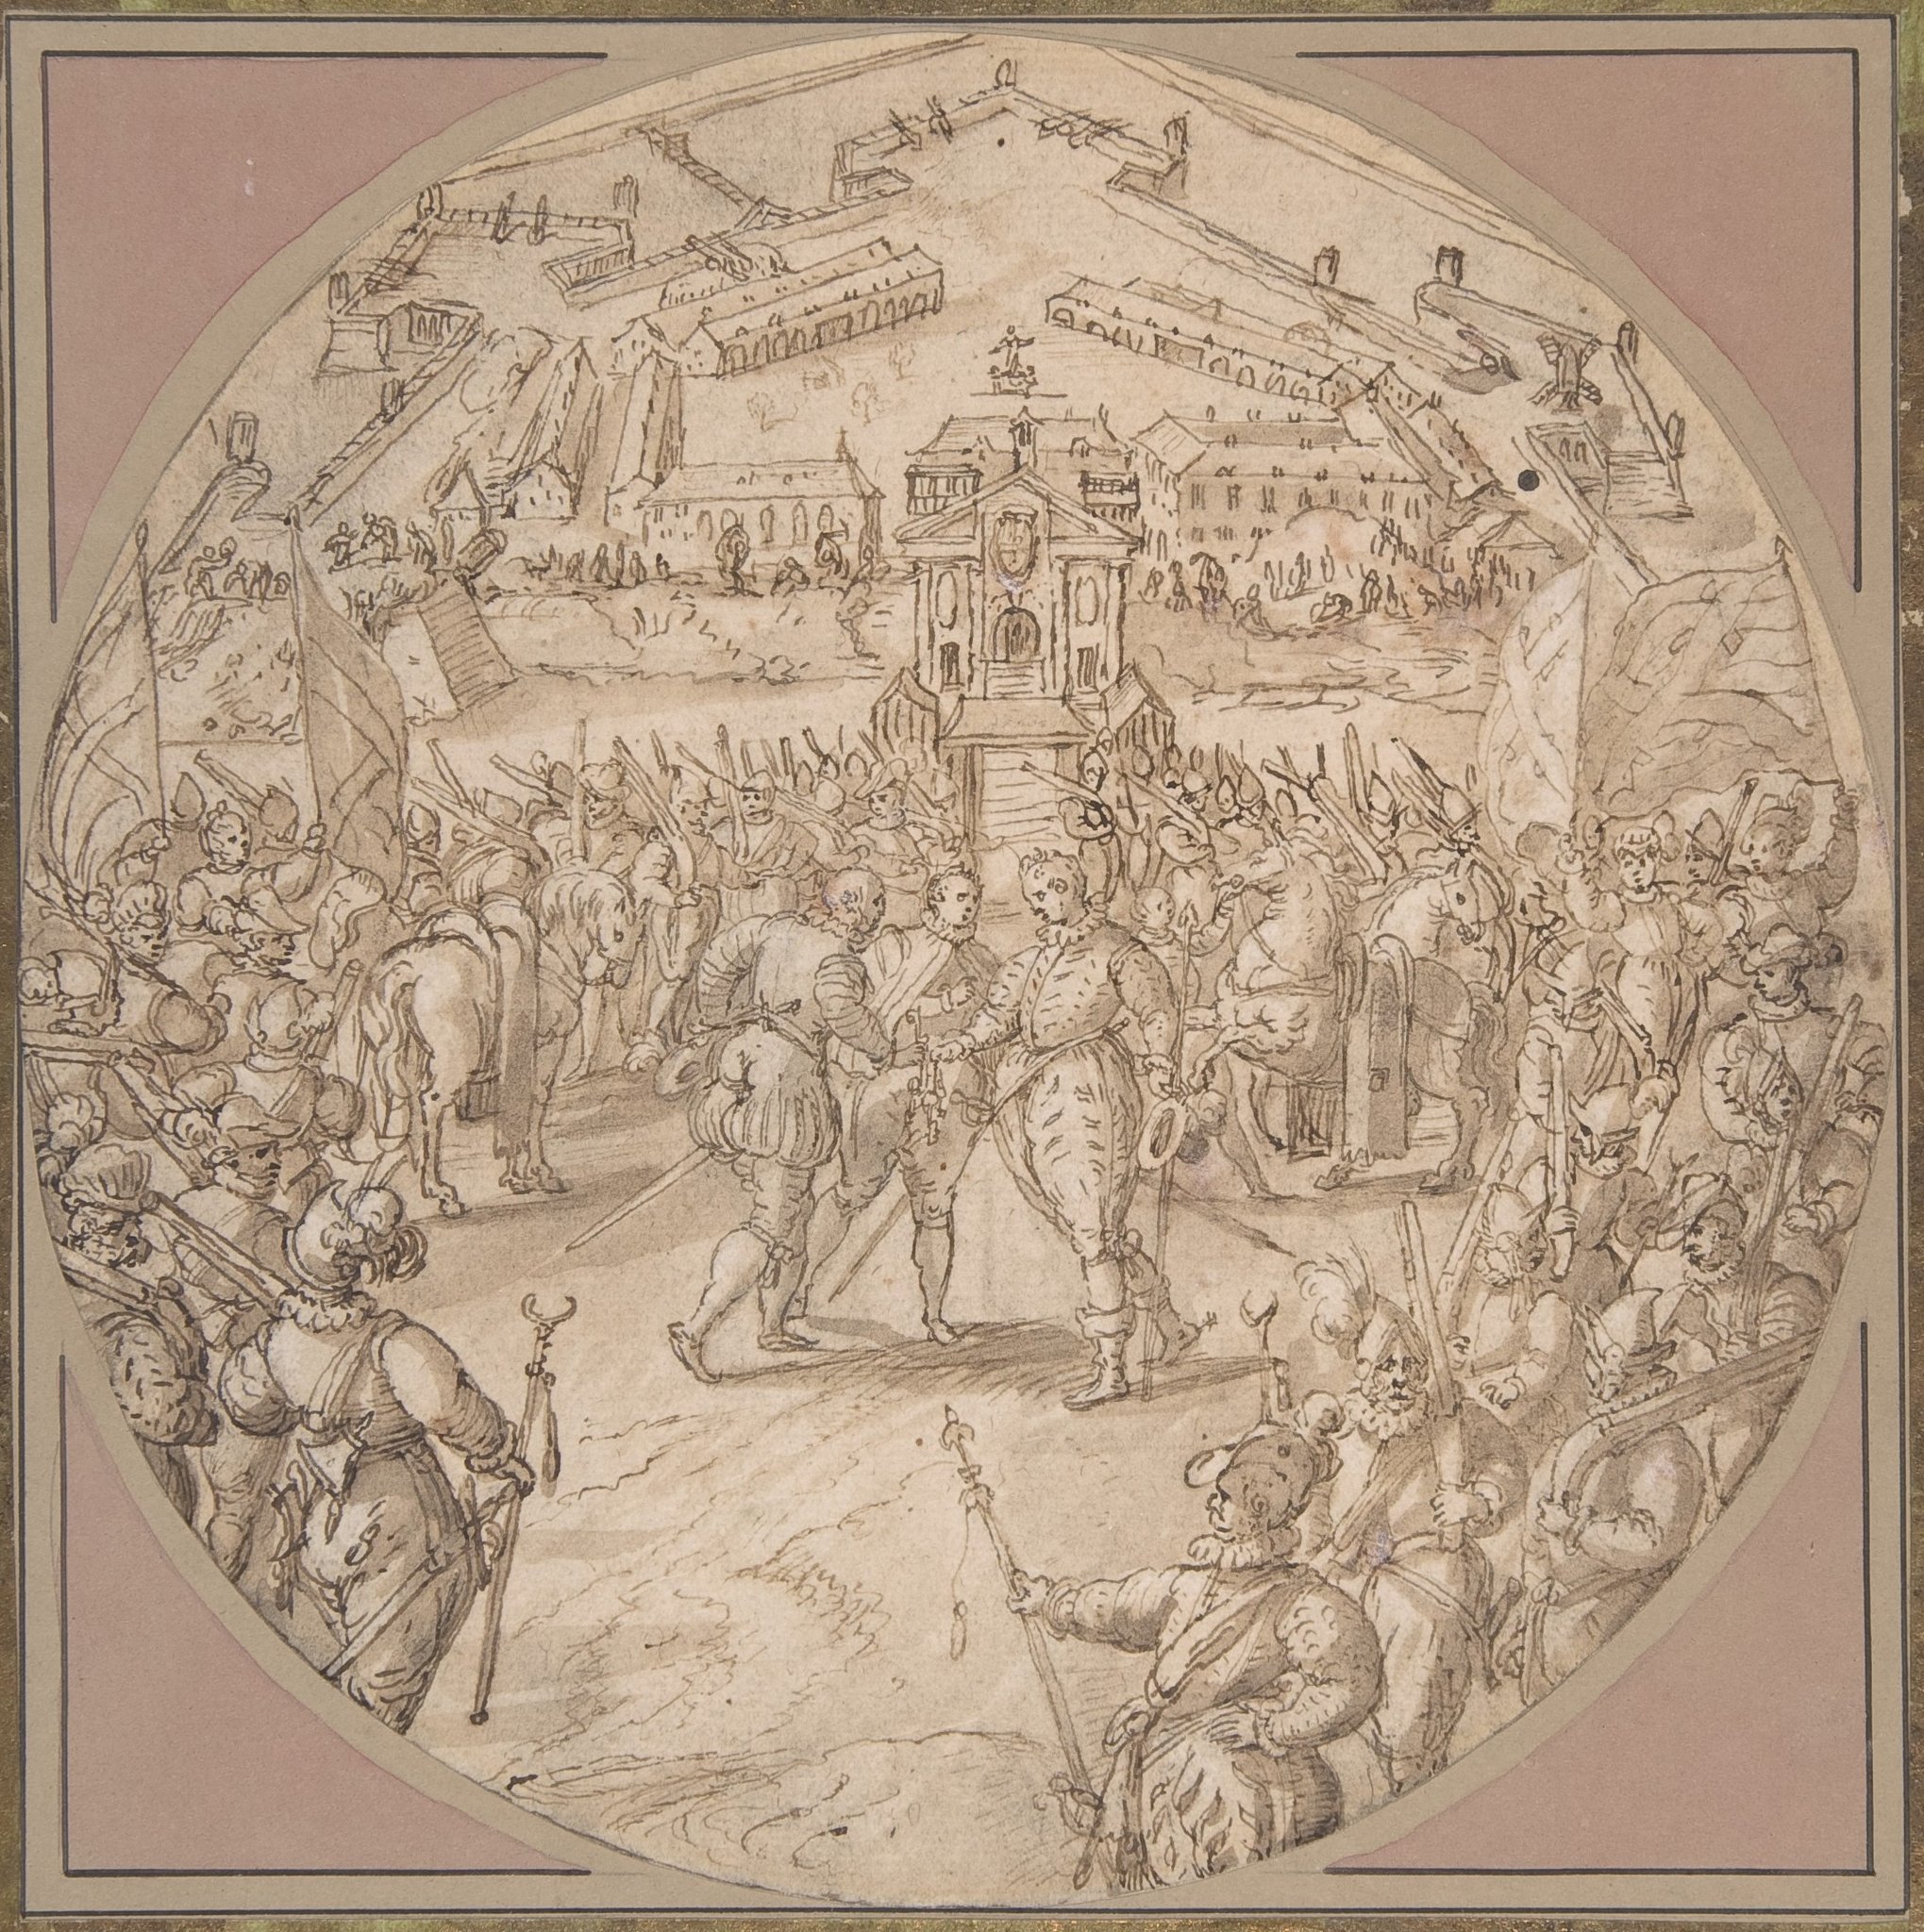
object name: drawing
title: Captain de Bours handing over the Keys to the Citadel of Antwerp to the Estates General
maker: maerten de vos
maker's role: artist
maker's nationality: netherlandish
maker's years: 1532-1603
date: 1534-1633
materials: gouache, ink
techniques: brush, incising, pen, transfer, wash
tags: houses,men,generals